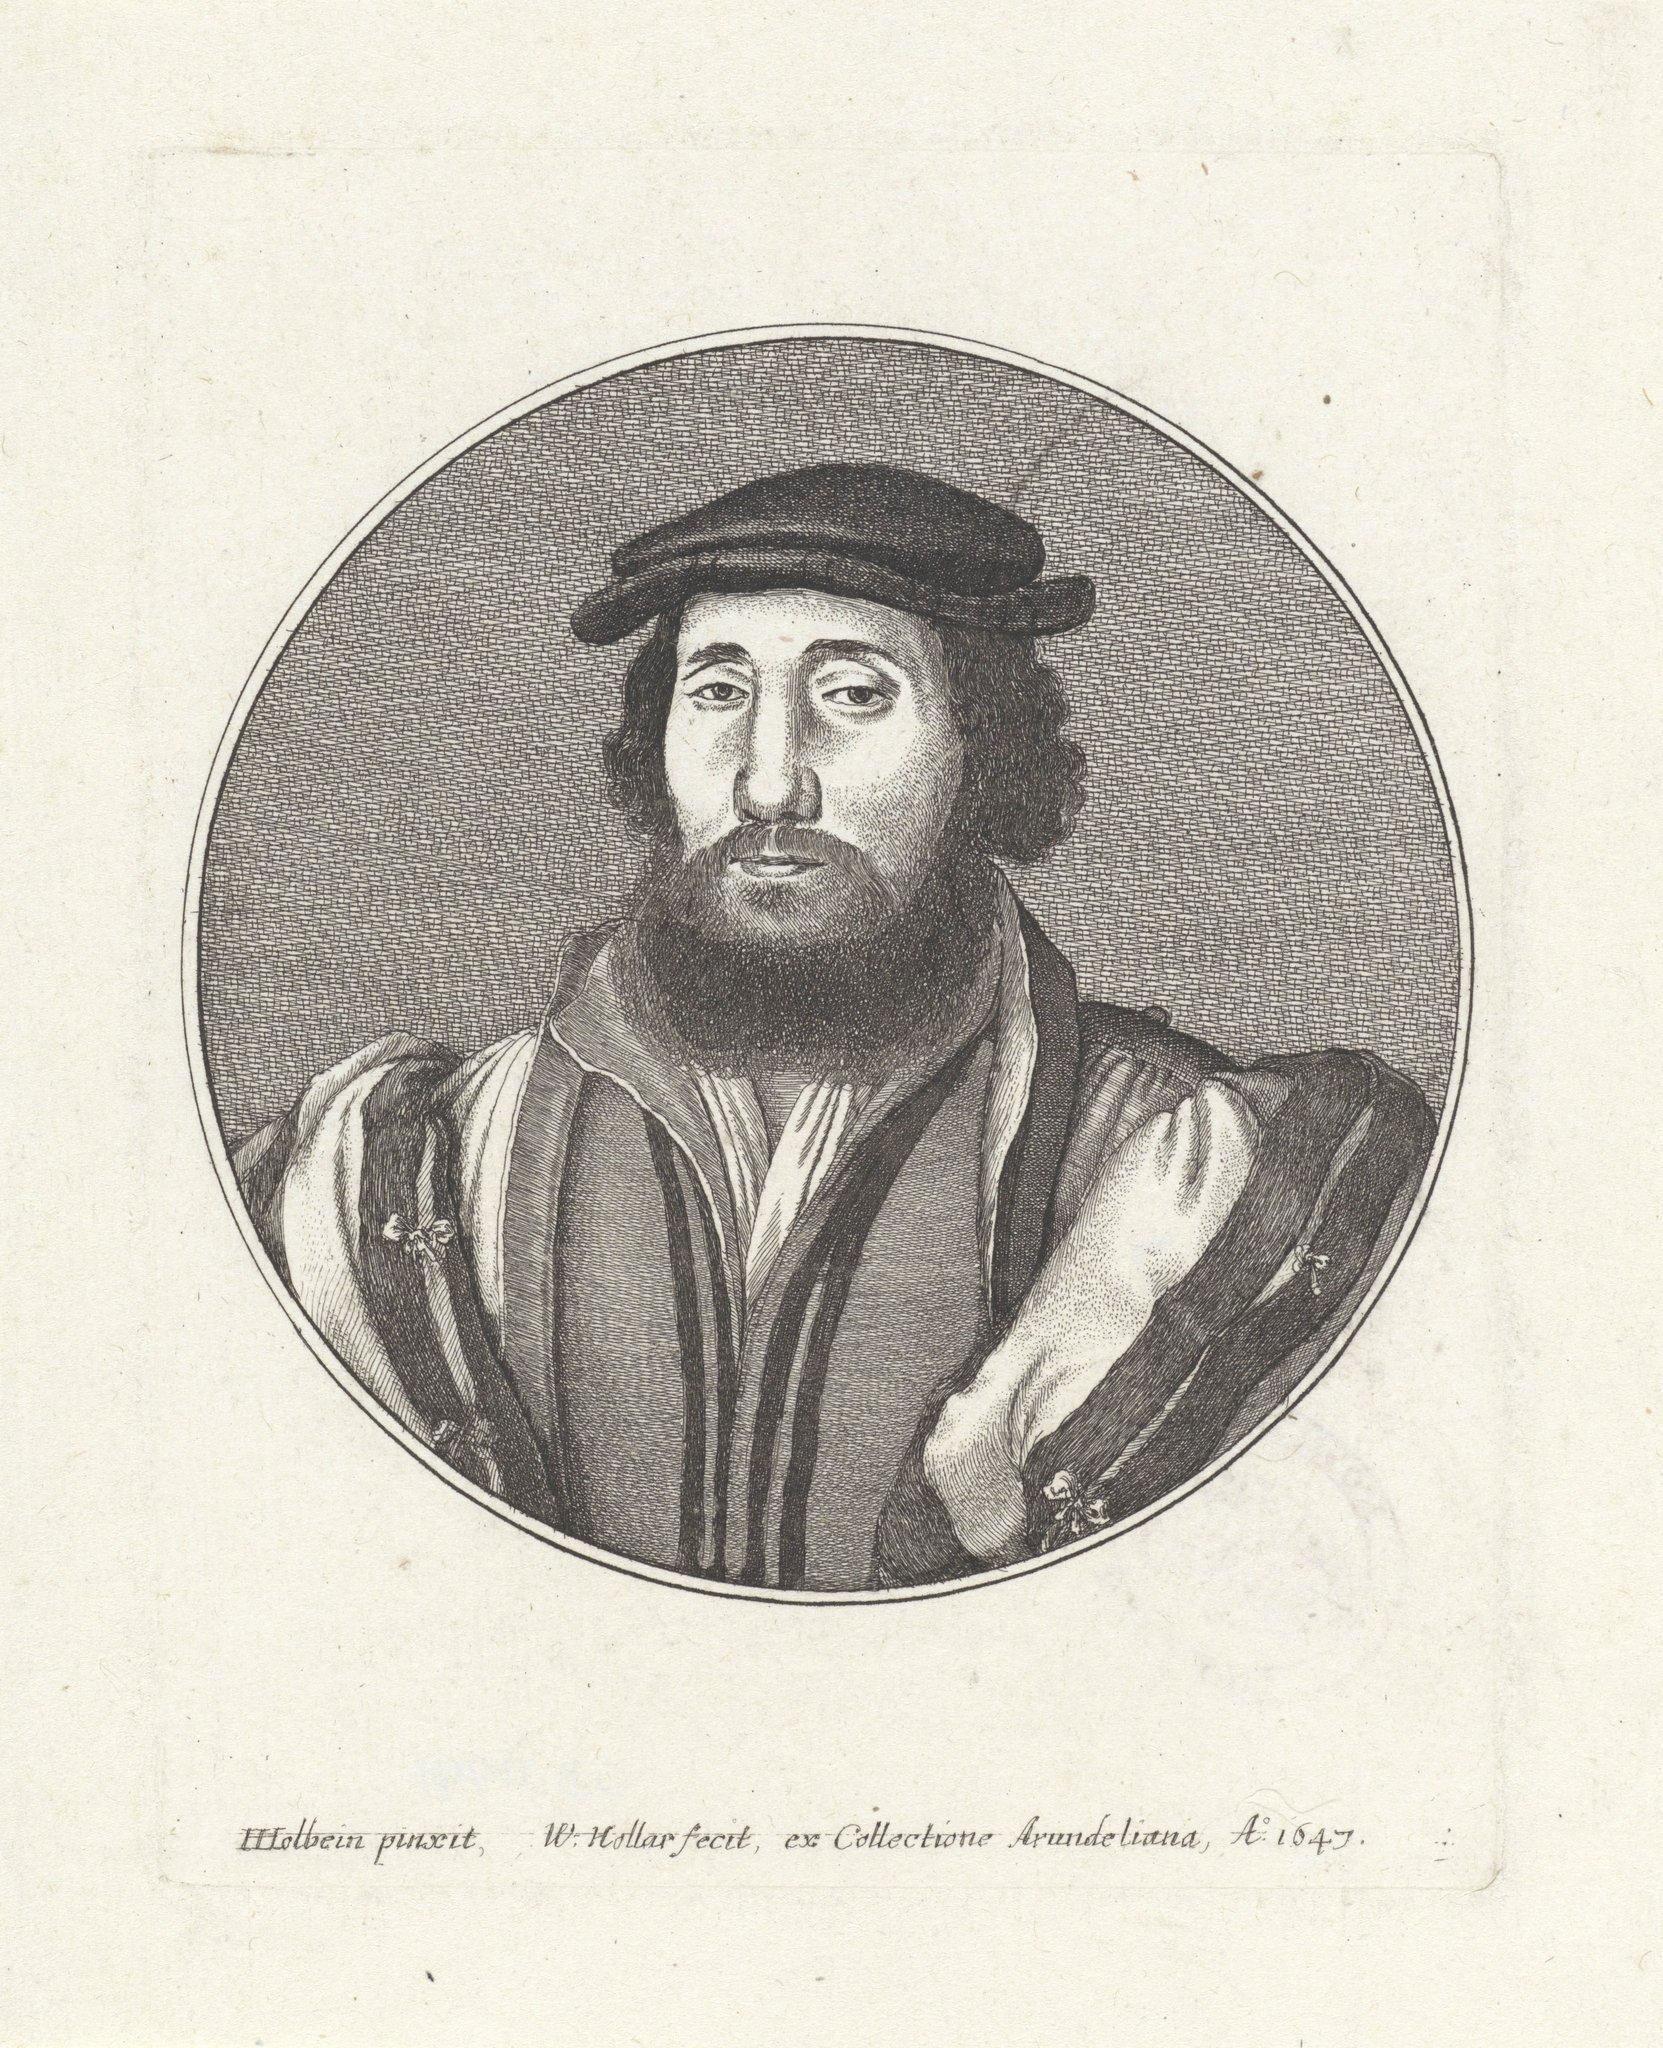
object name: print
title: Portret van een man met baard en baret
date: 1647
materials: paper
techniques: etching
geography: antwerp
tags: head-gear (bonnet) (+ men's clothes), anonymous historical person portrayed alone, beard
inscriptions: collector's mark: Lugt 240